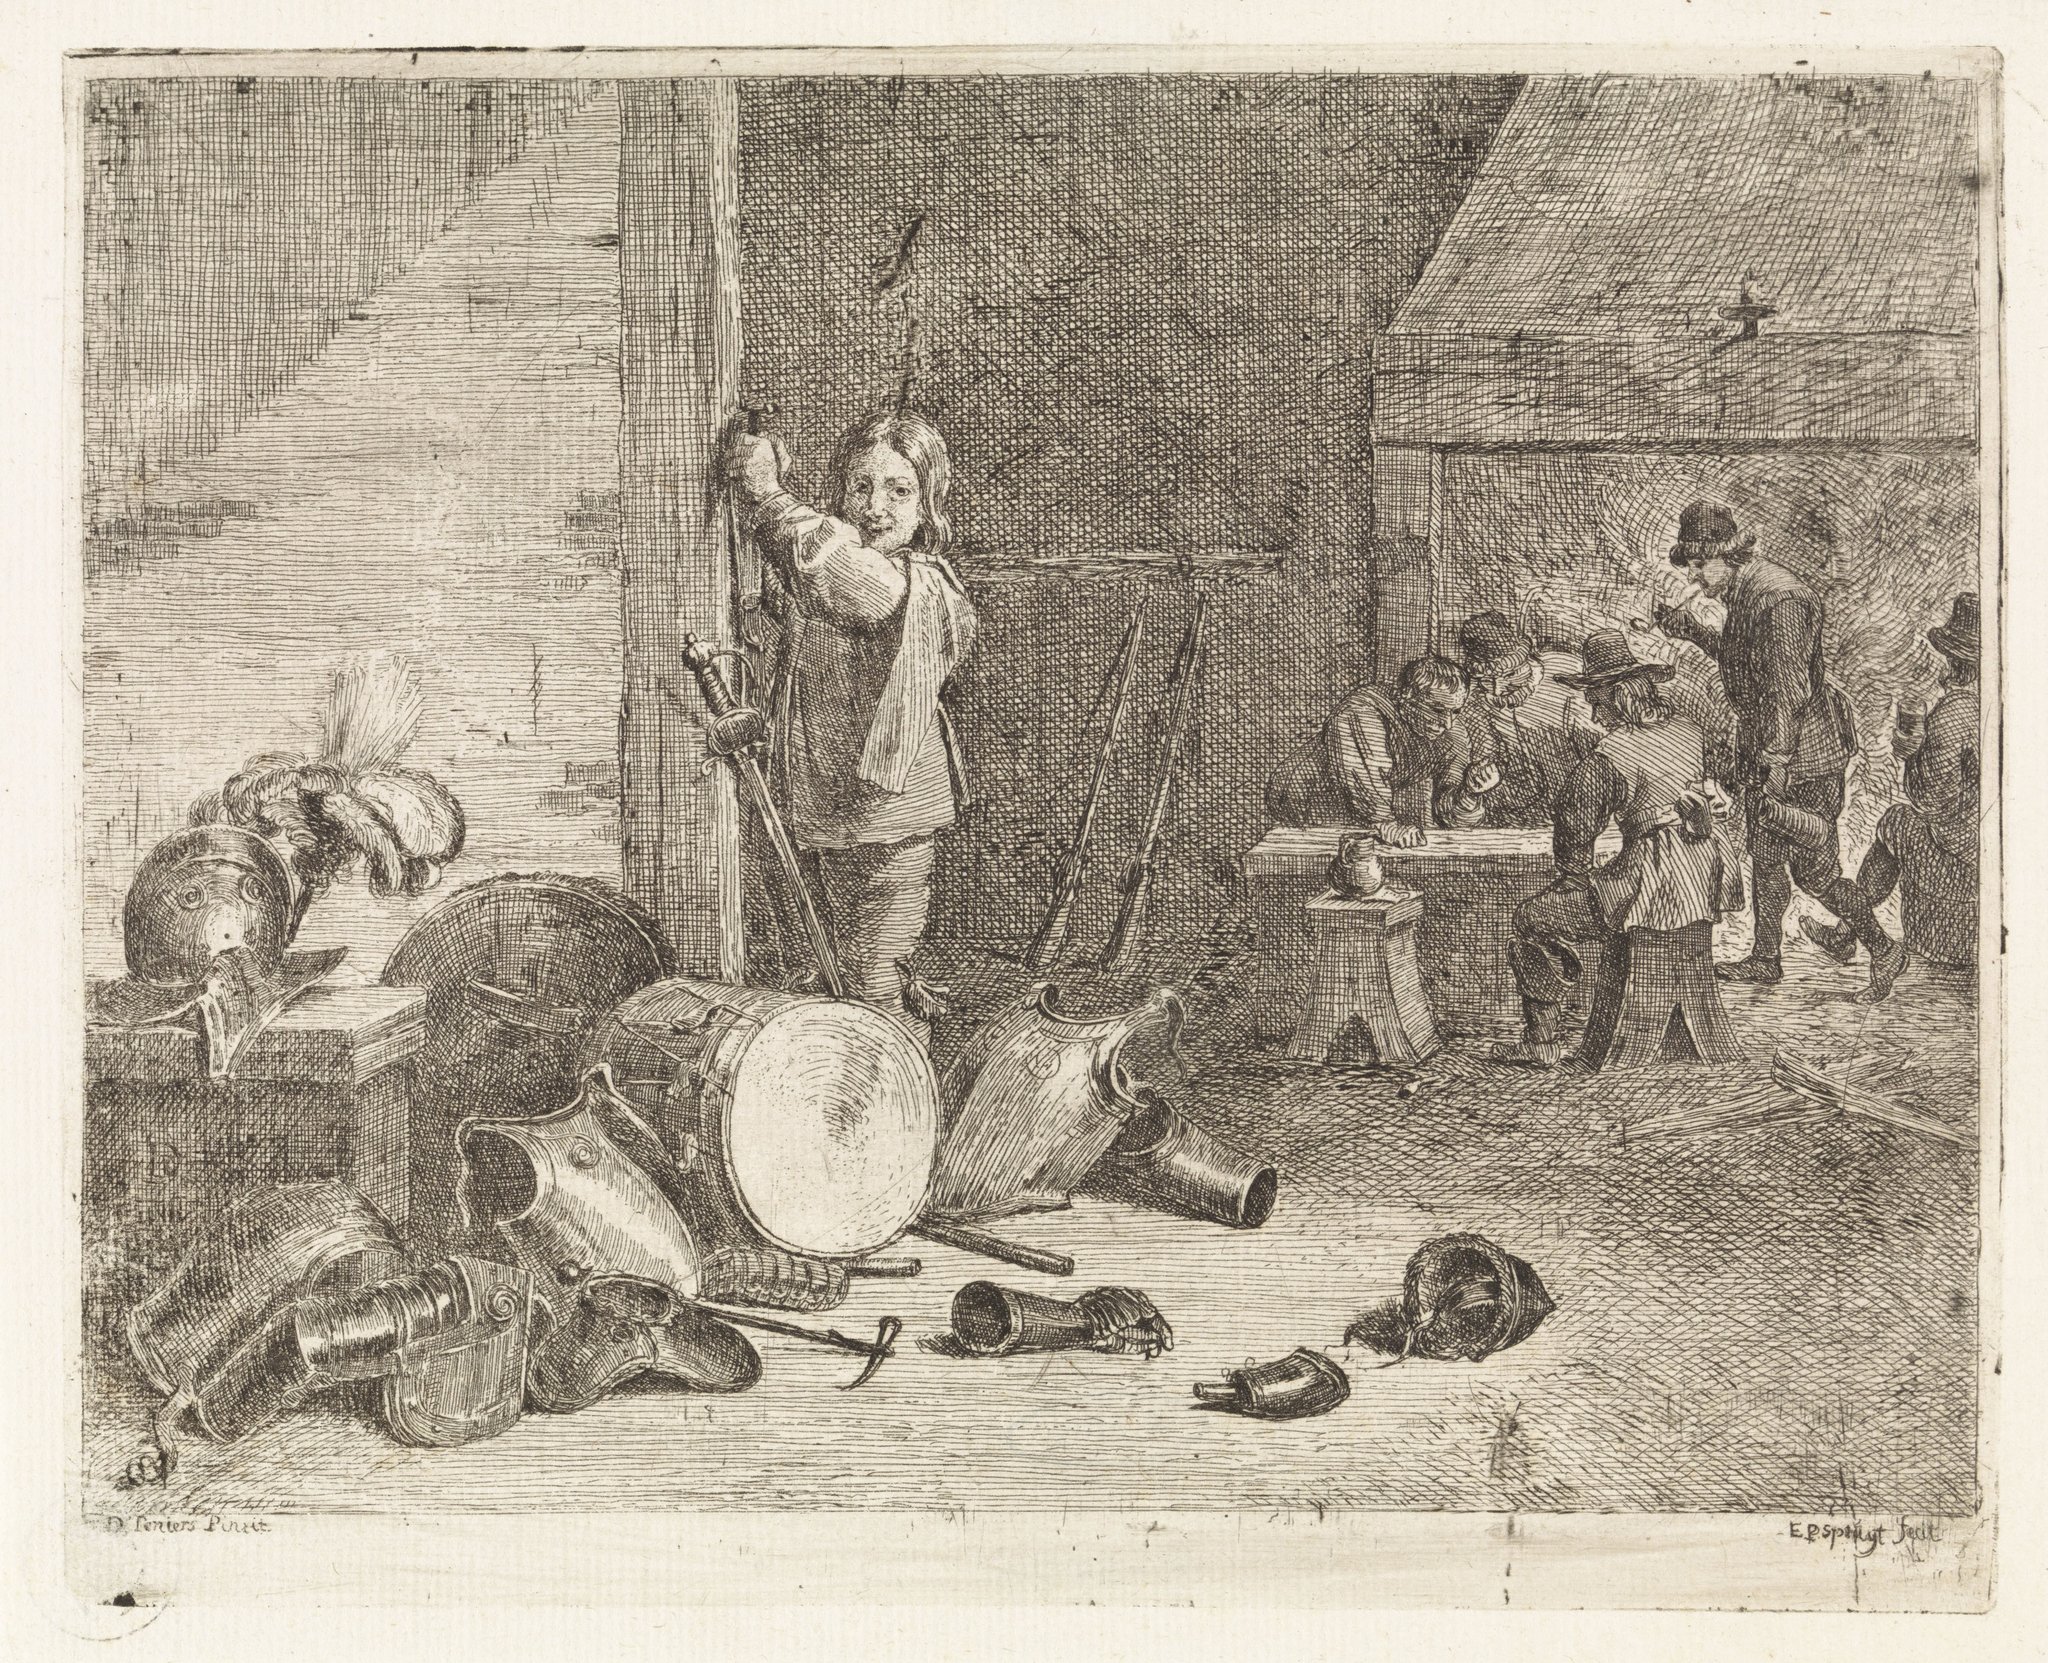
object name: print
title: Interieur met jongen bij een trom en wapenrusting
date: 1747-1801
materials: paper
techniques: etching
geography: ghent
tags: armour, drum (musical instrument), indoor recreation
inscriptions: collector's mark: Lugt 2228, collector's mark: Lugt 514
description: In een interieur staat een jongen bij de verschillende onderdelen van een wapenrusting en een trommel. Op de achtergrond mannen rond een tafel bij de haard.